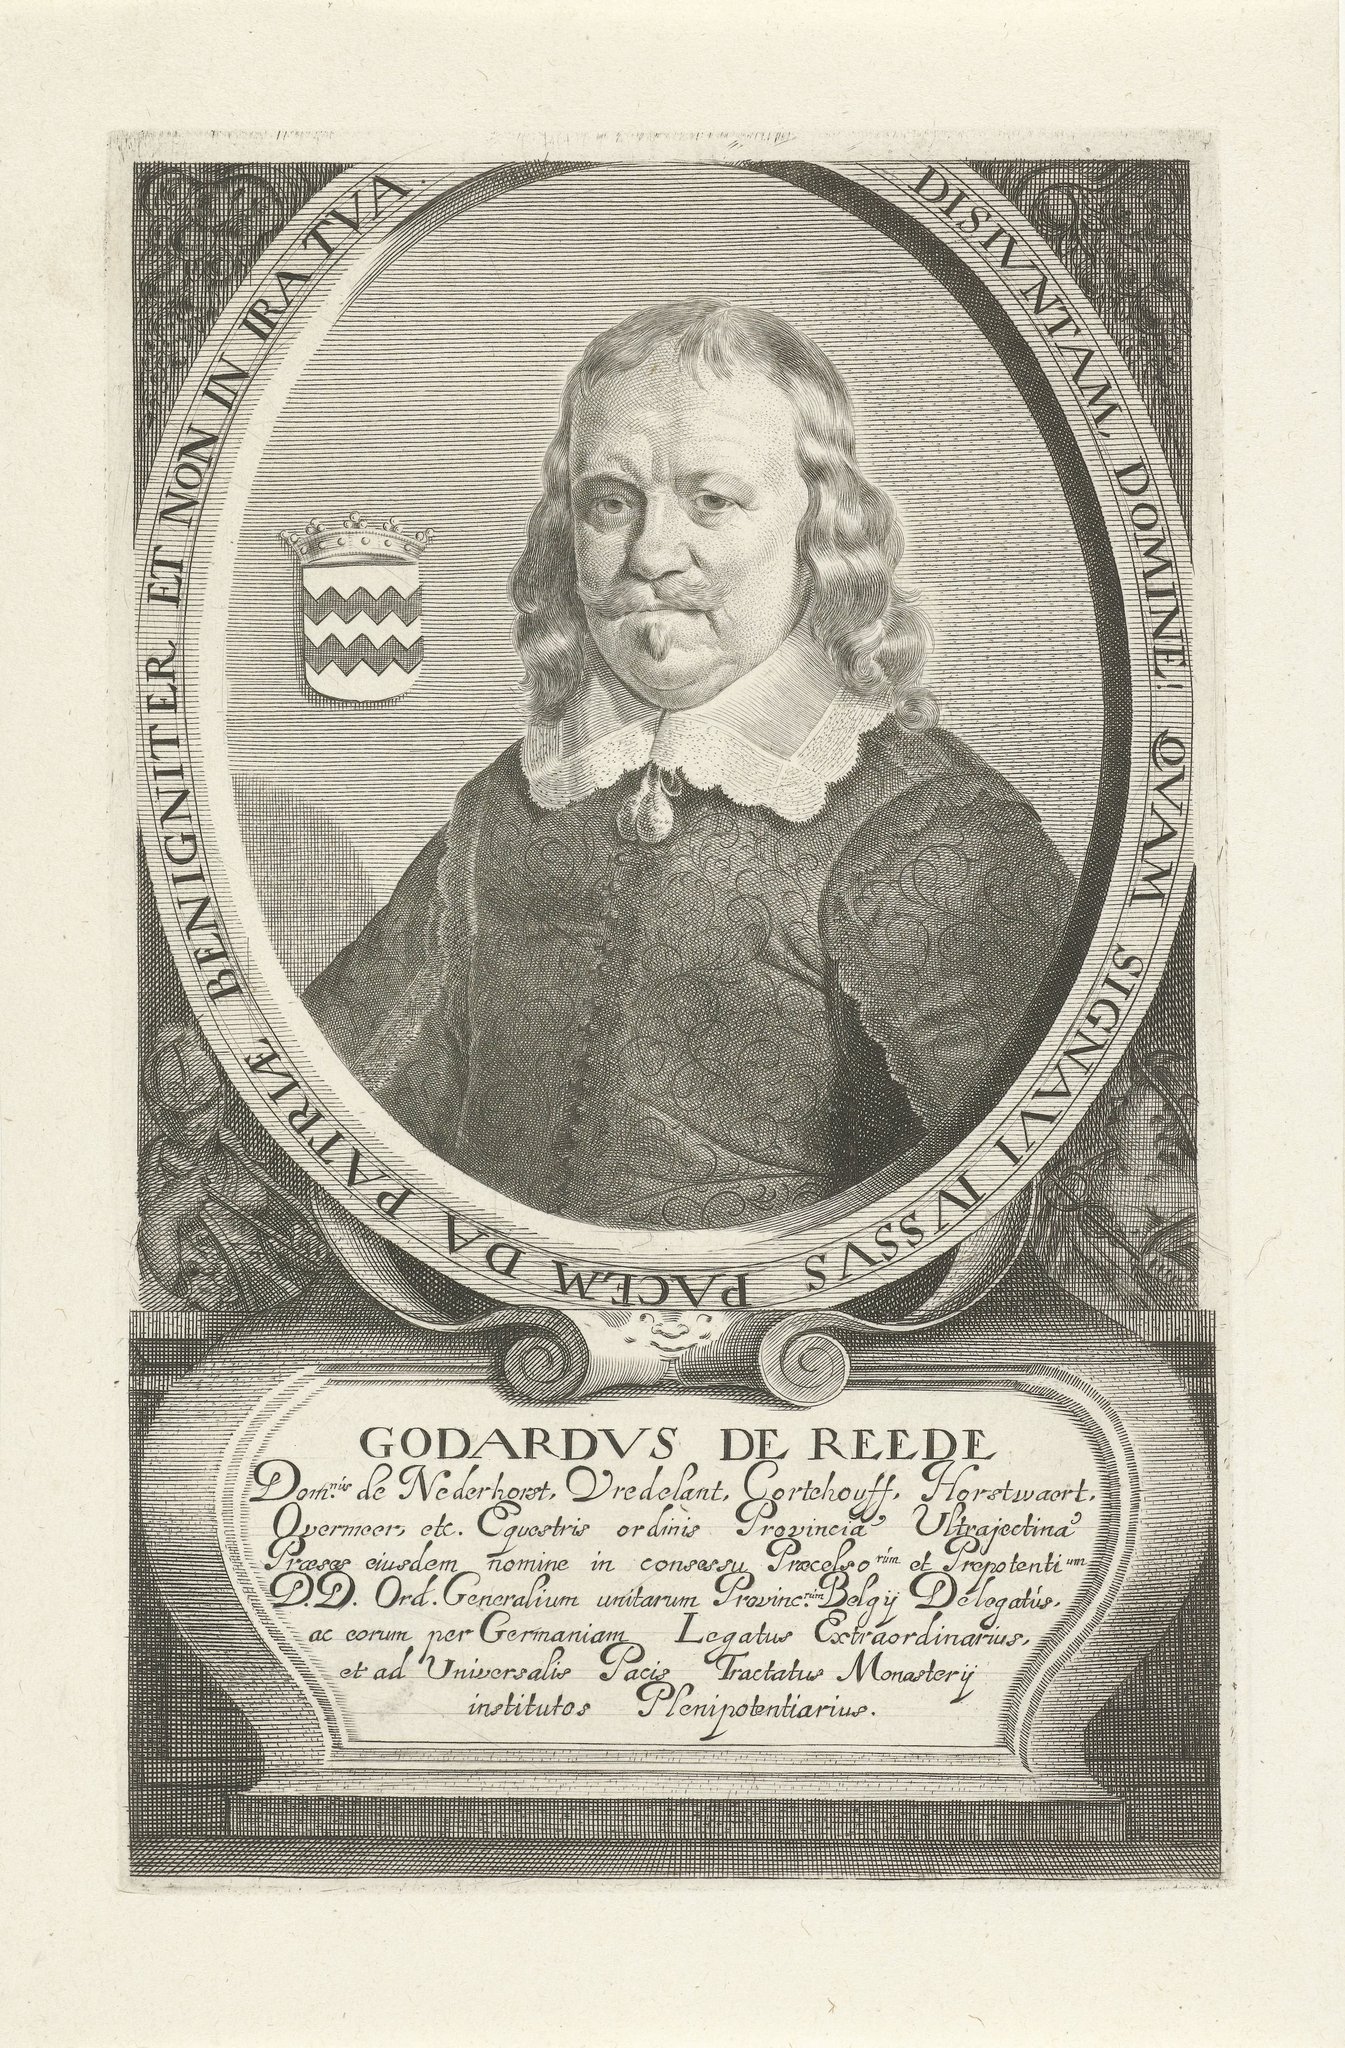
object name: print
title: Portret van Godard van Reede van Nederhorst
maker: pieter holsteyn (ii)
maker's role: draughtsman, print maker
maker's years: 1614-1673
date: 1648-1673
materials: paper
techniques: engraving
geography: northern netherlands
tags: utrecht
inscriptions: collector's mark: Lugt 2228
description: Portret naar links van Godard van Reede van Nederhorst in een ovaal met randschrift in het Latijn. Links zijn wapen. Onder het portret zijn naam en zeven regels in het Latijn op een piëdestal. Prent uit een serie portretten van ambassadeurs betrokken bij het vredesverdrag van Munster.